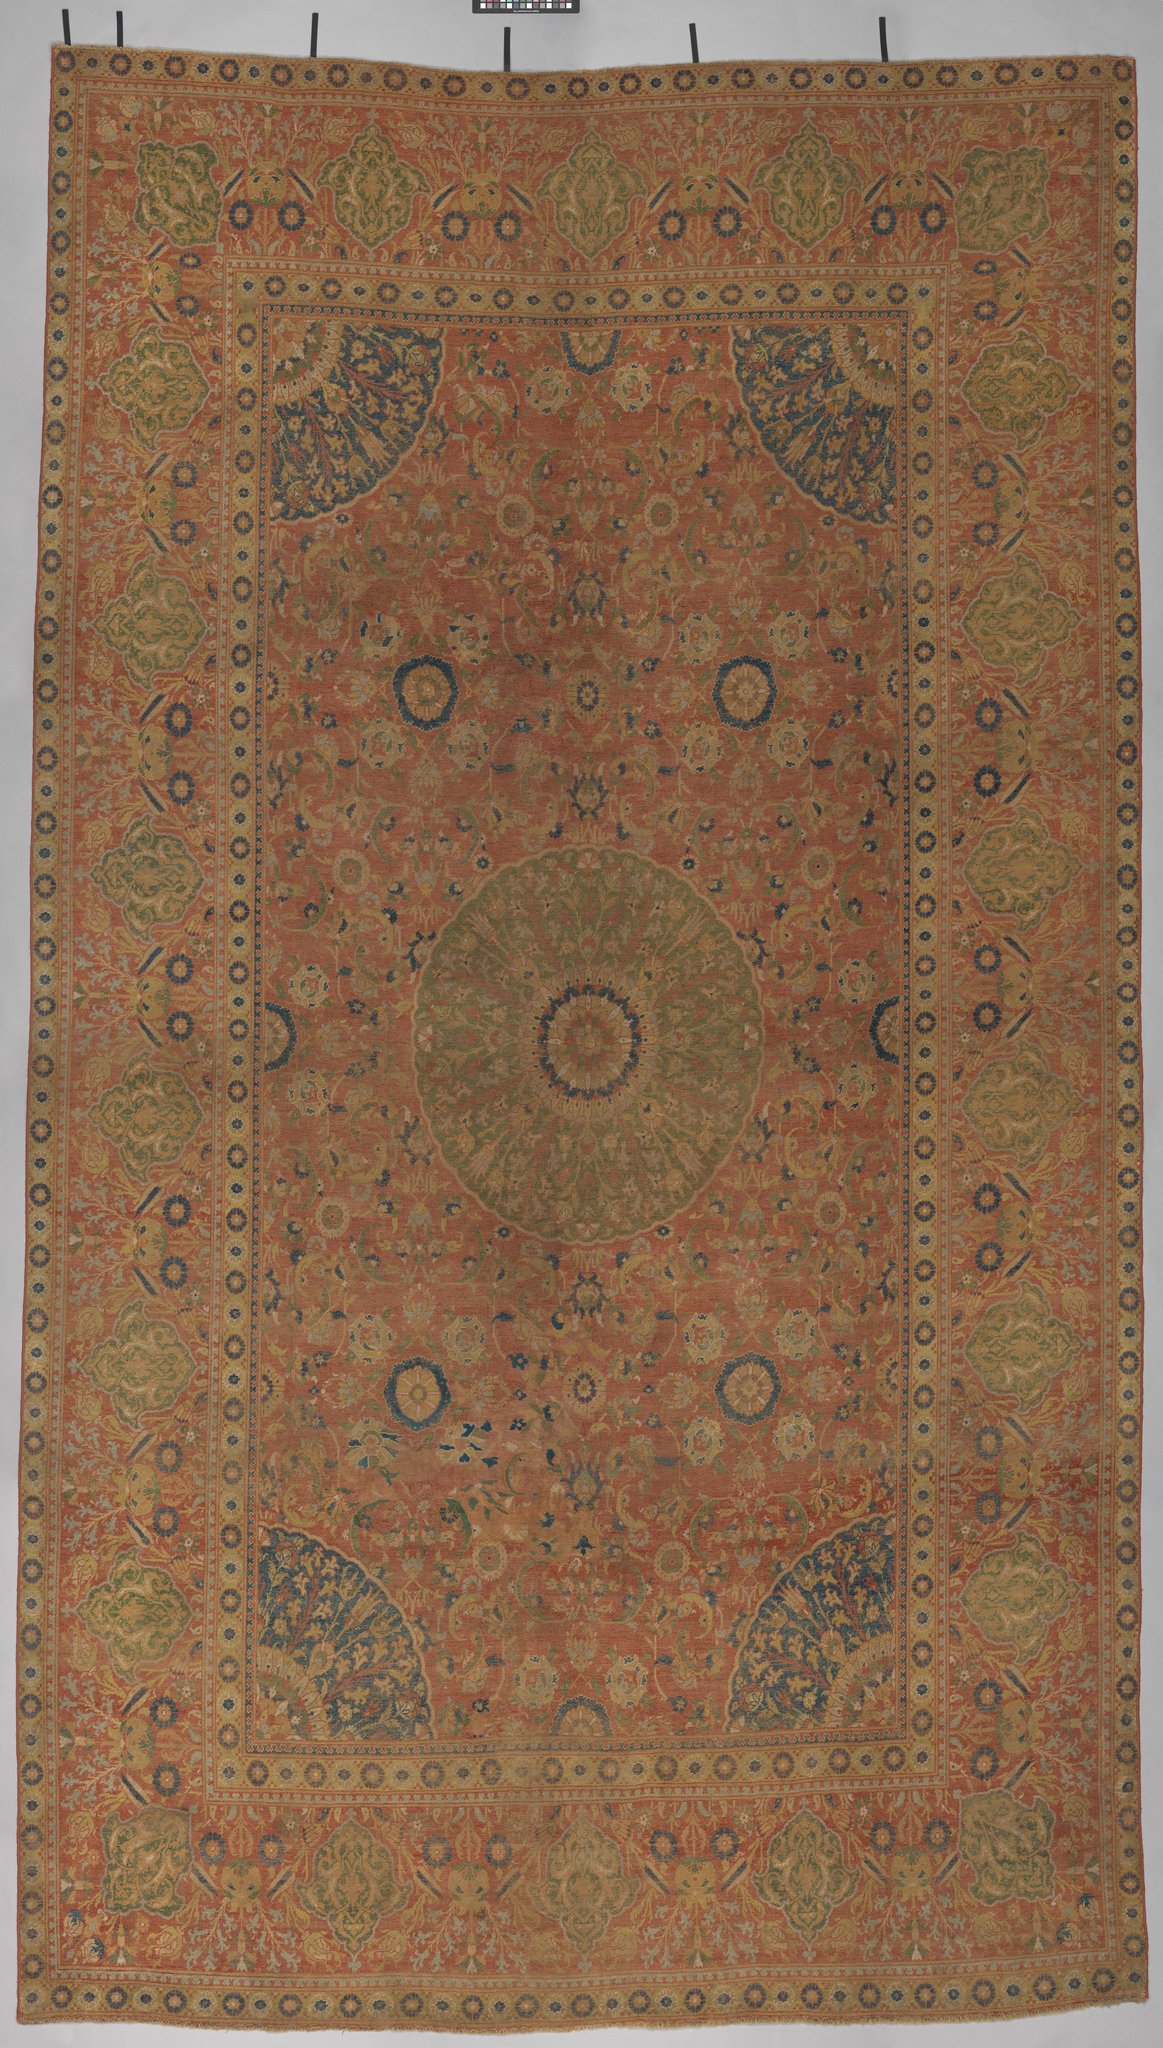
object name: carpet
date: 1601-1700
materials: wool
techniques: asymmetrically knotted pile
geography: egypt